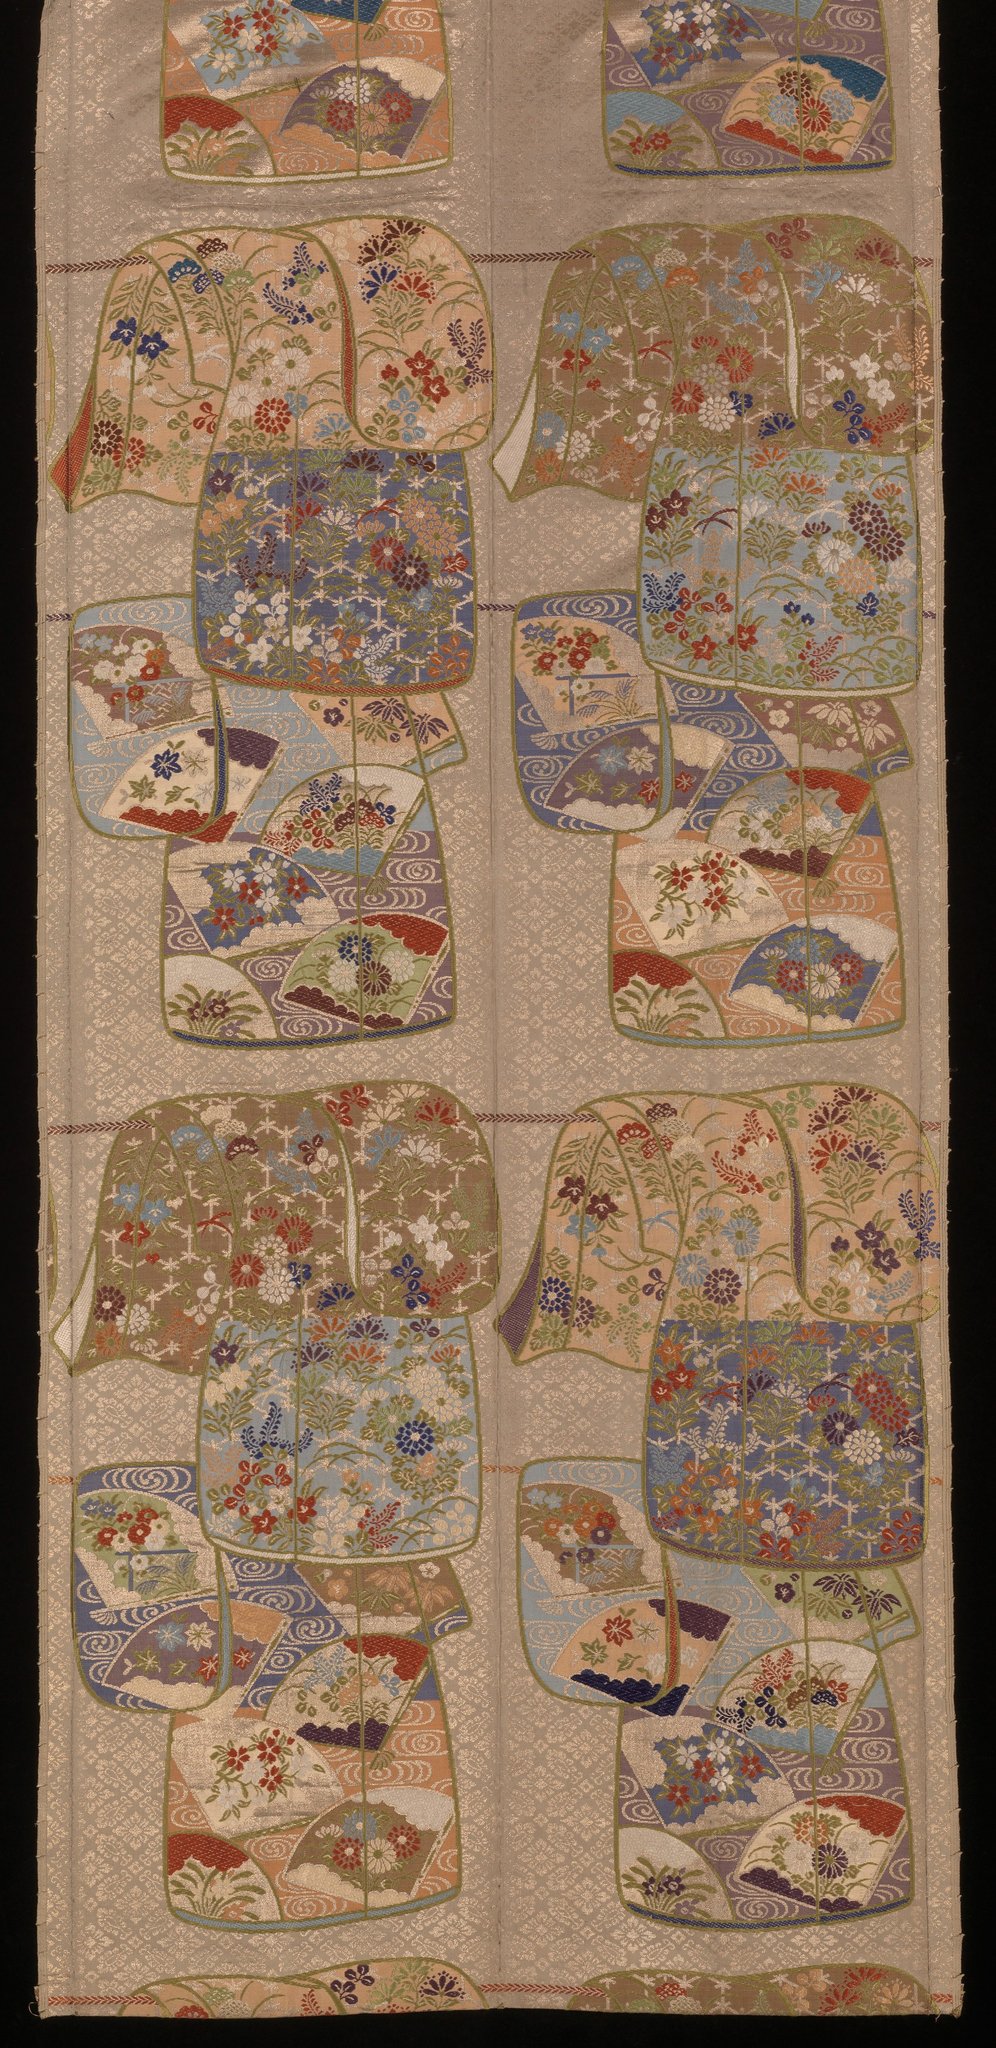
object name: obi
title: Obi with “Whose Sleeves?” (Tagasode) Pattern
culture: japanese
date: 1801-1850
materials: metal thread, silk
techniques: patterning, weave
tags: robes